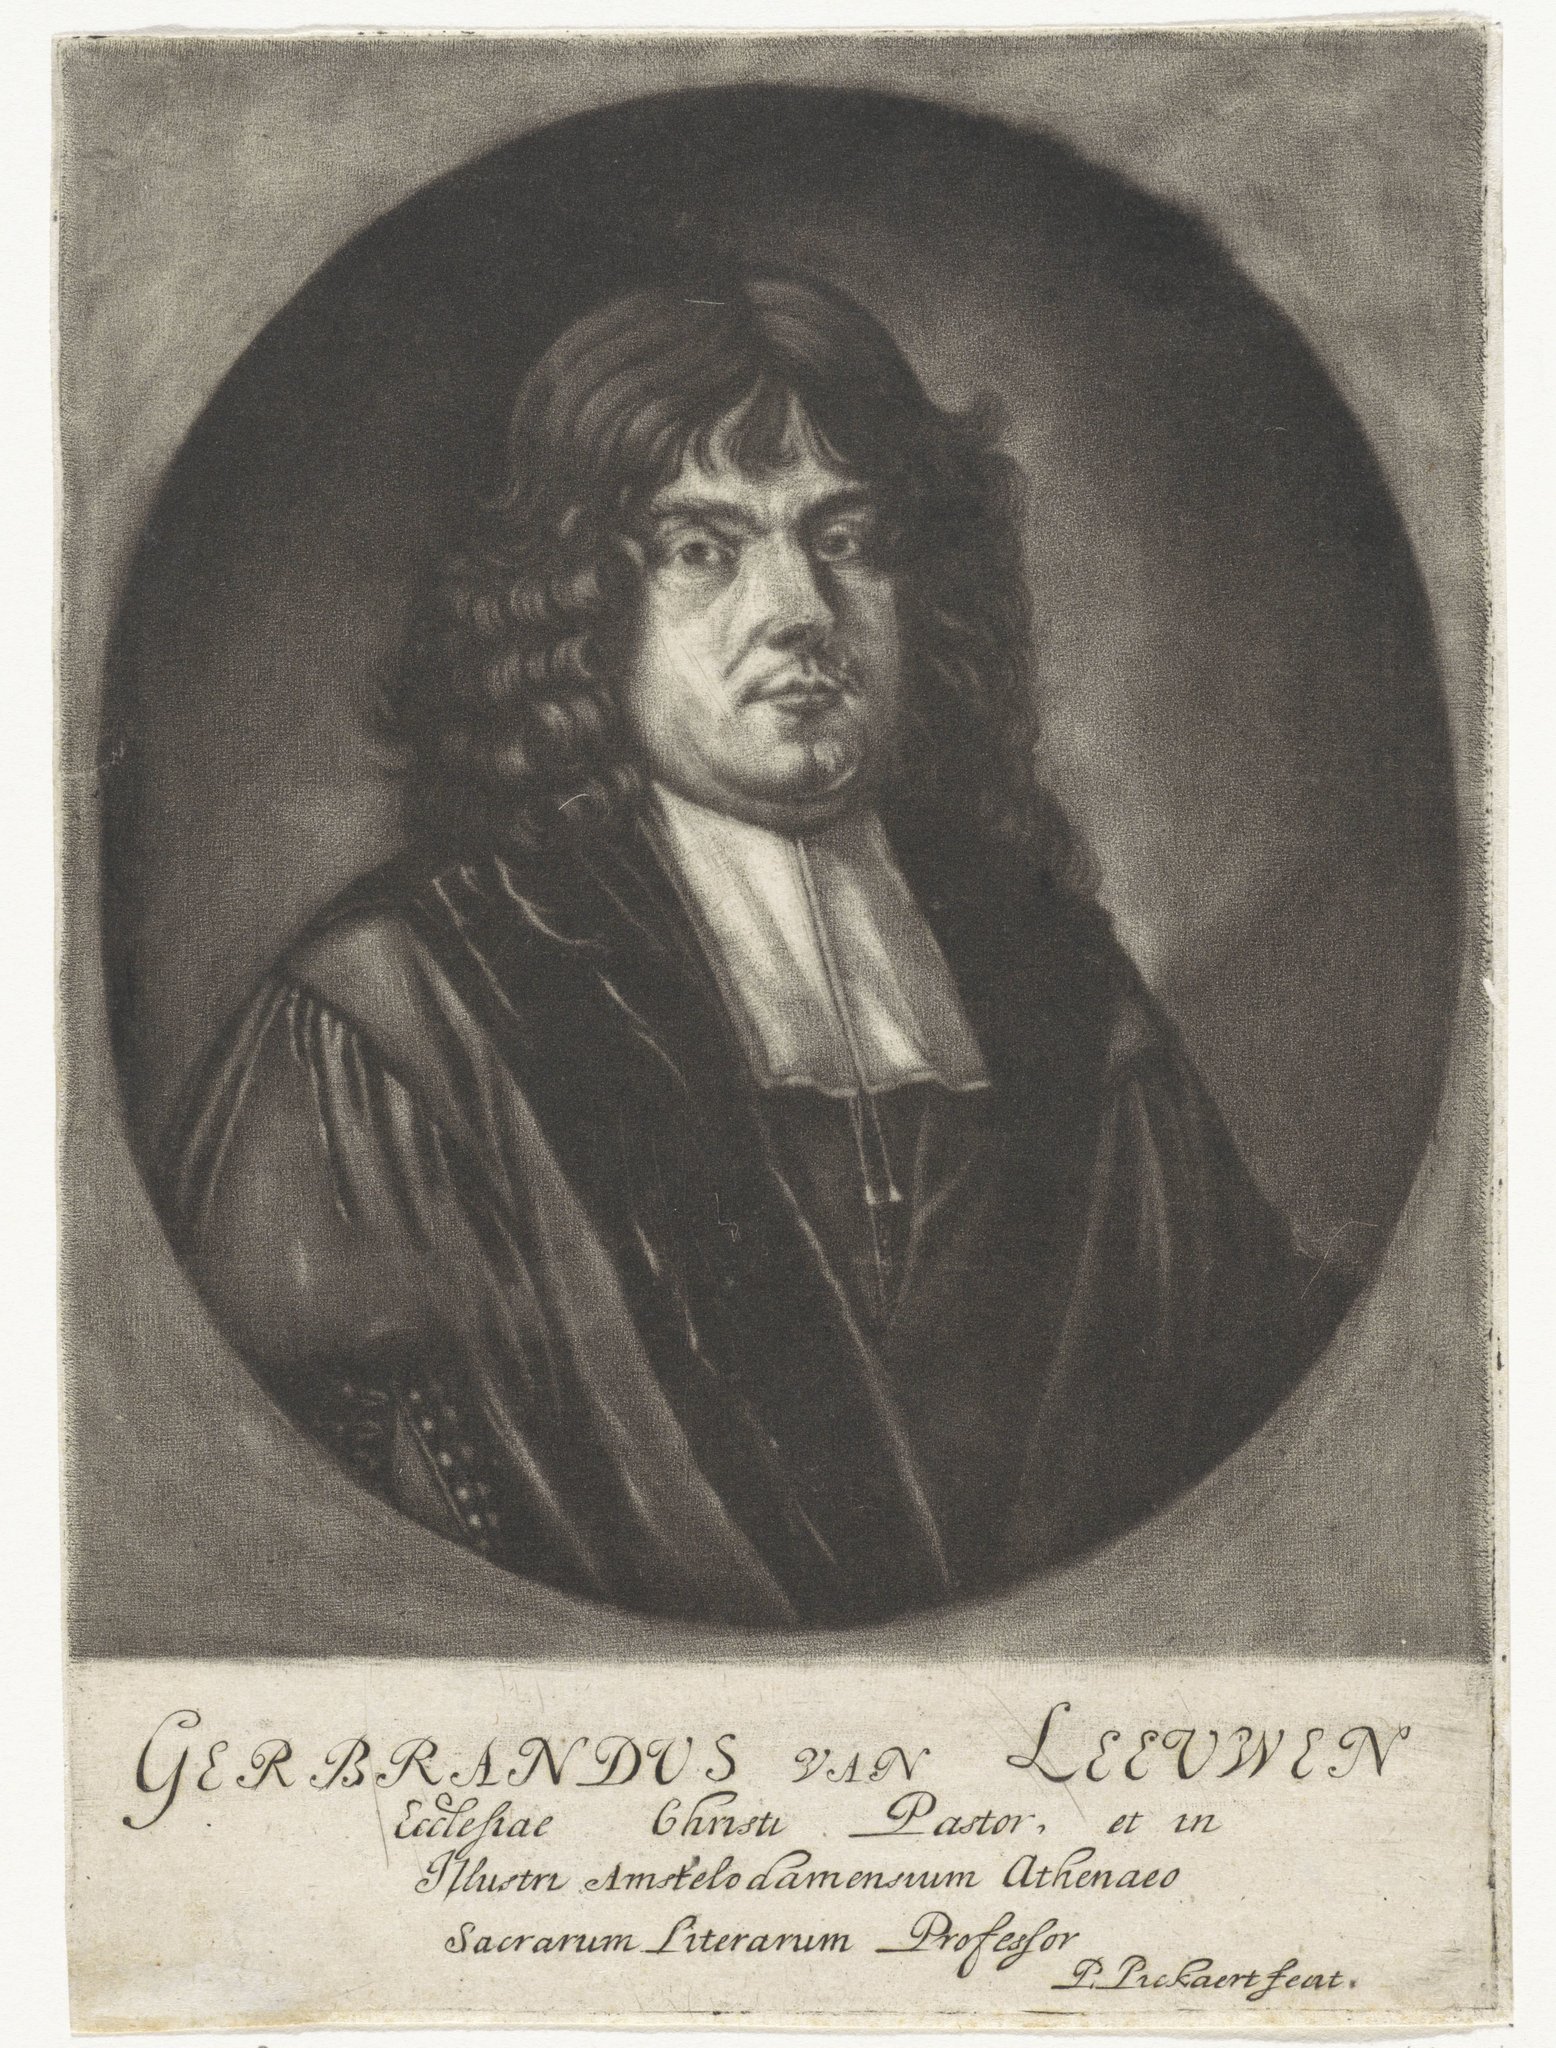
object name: print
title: Portret van Gerbrand van Leeuwen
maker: pieter pickaert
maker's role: print maker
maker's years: 1668-1737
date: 1680-1715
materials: paper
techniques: engraving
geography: amsterdam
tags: predikant, hoogleraar, gerbrand van leeuwen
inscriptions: collector's mark: Lugt 2228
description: De predikant en hoogleraar Gerbrand van Leeuwen.